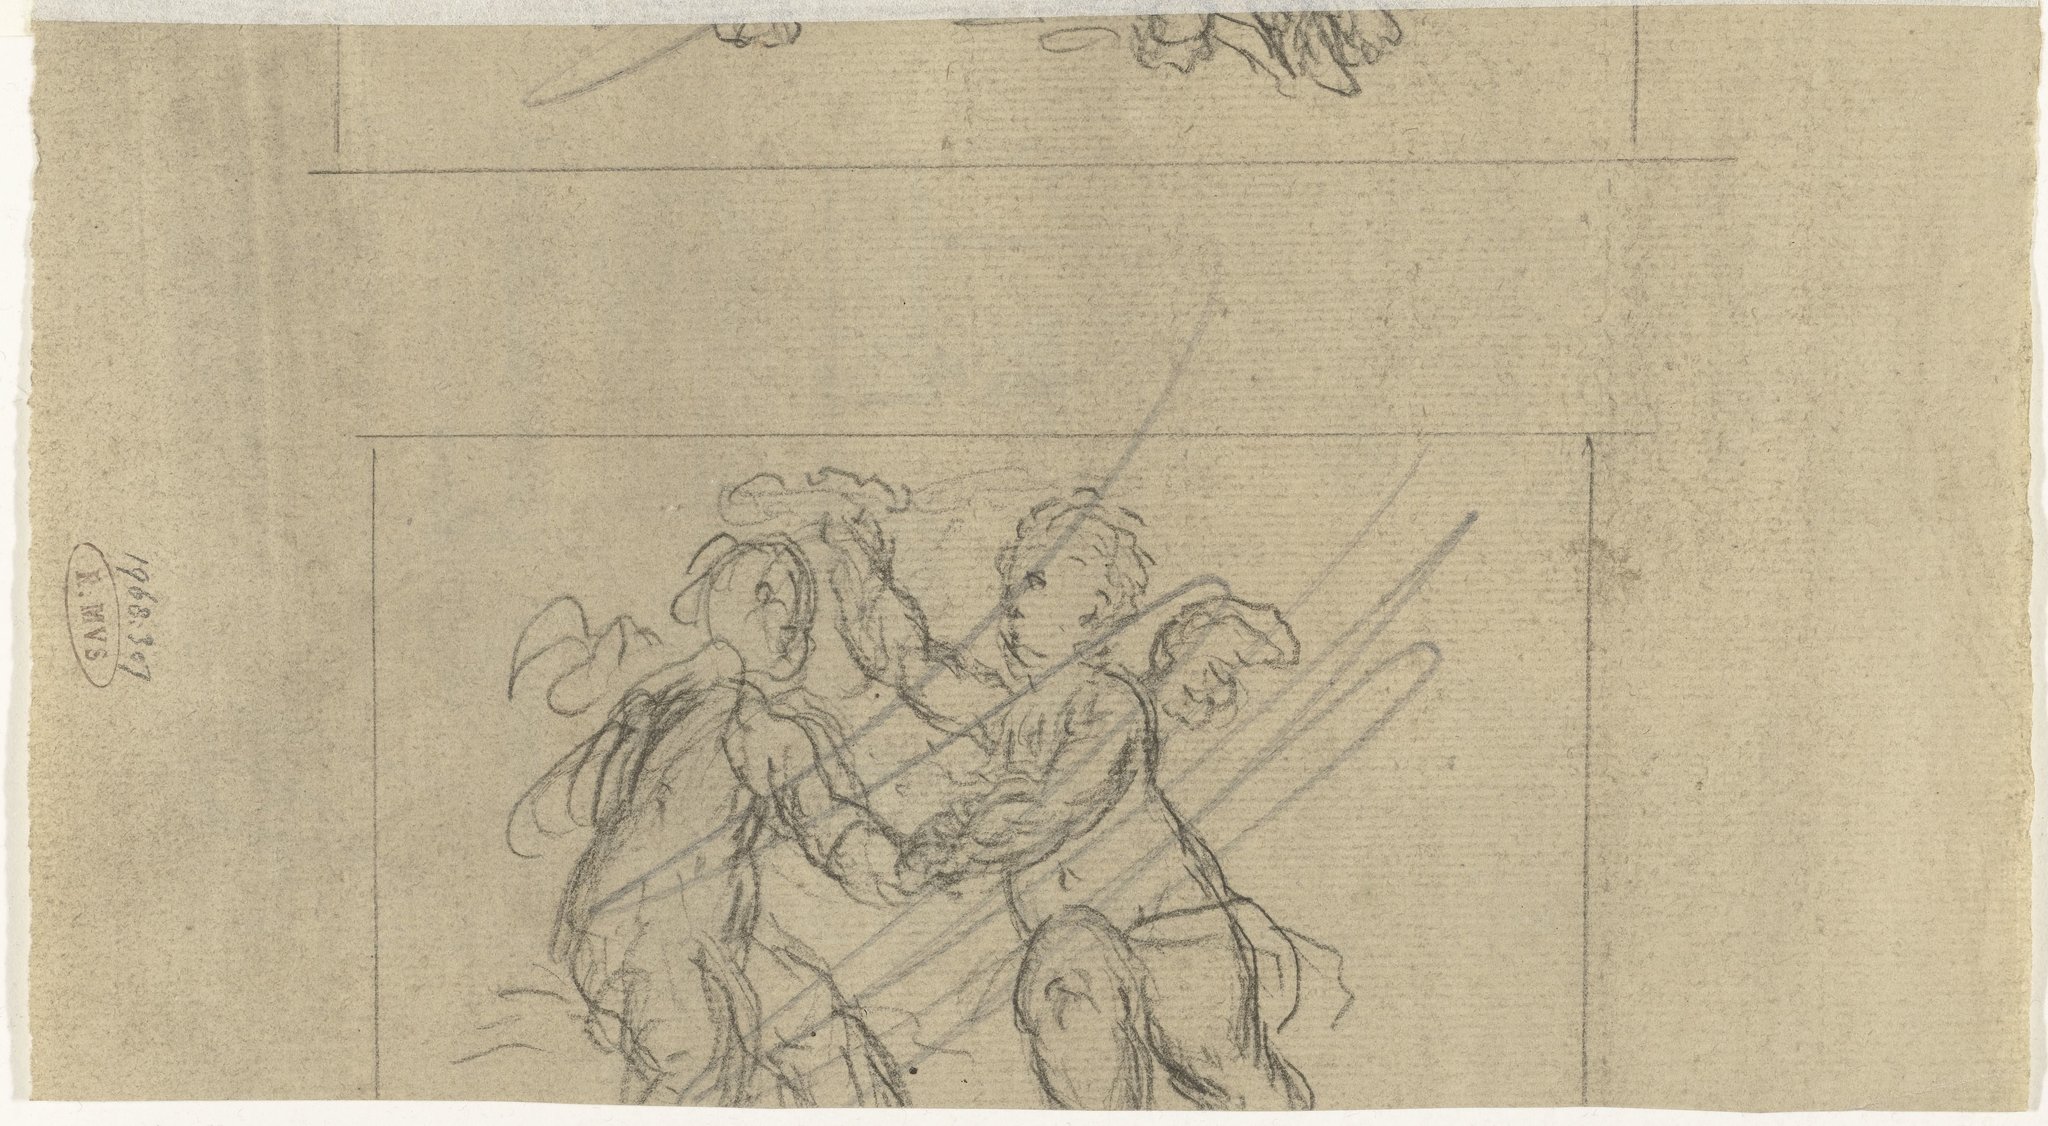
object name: design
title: Fragment van een studie met twee putti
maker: dionys van nijmegen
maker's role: draughtsman, painter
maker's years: 1705-1798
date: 1715-1798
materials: chalk, paper